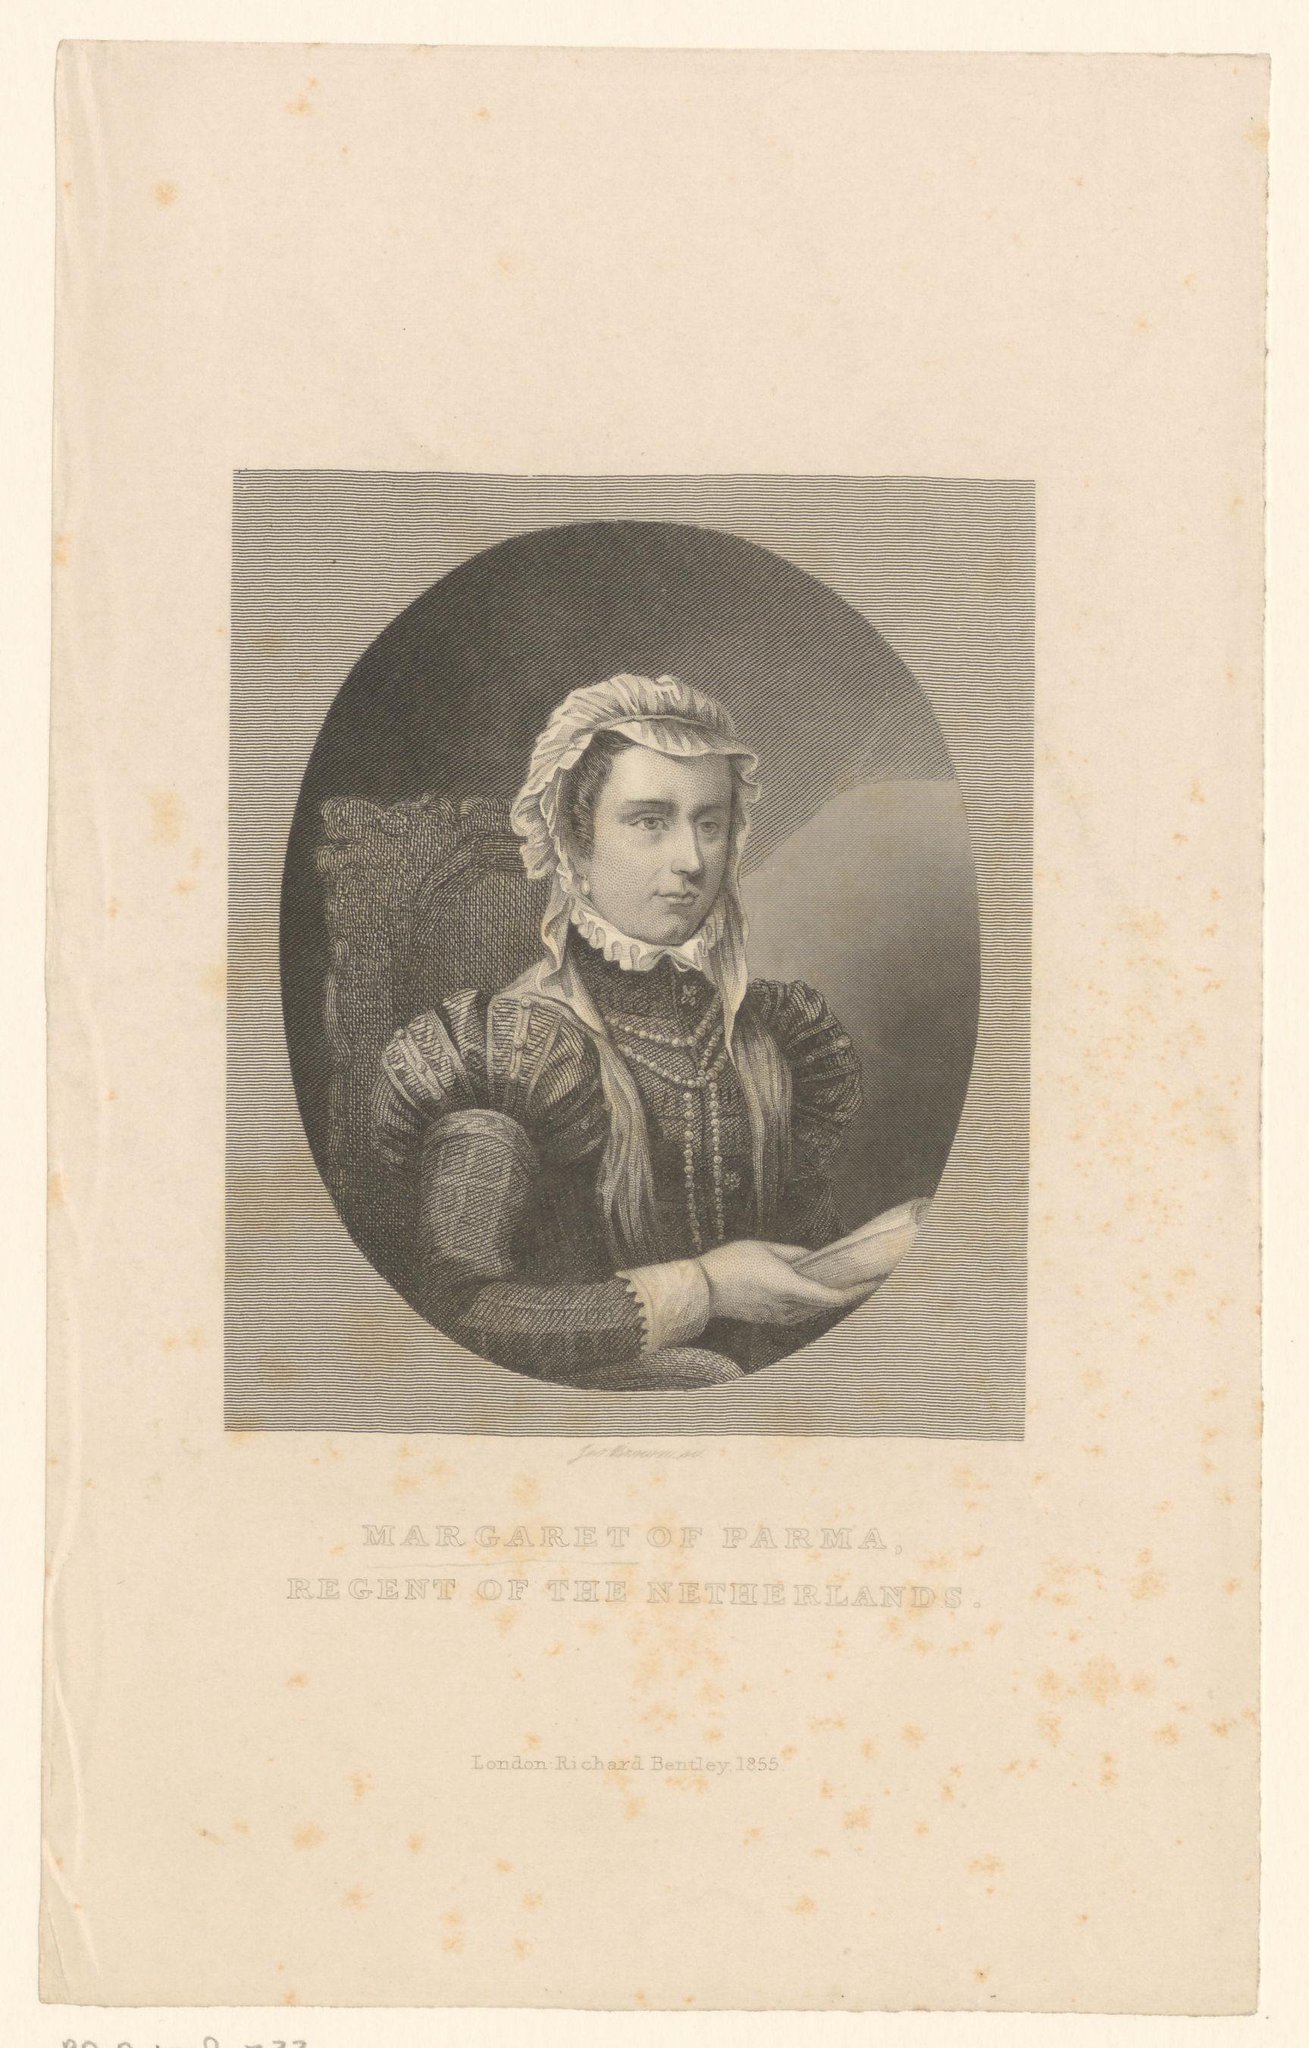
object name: print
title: Portret van Margaretha van Parma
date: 1855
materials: paper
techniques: engraving, etching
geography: london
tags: historical persons, regent, substitute ruler; viceroy - bb - female ruler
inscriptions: collector's mark: Lugt 2228